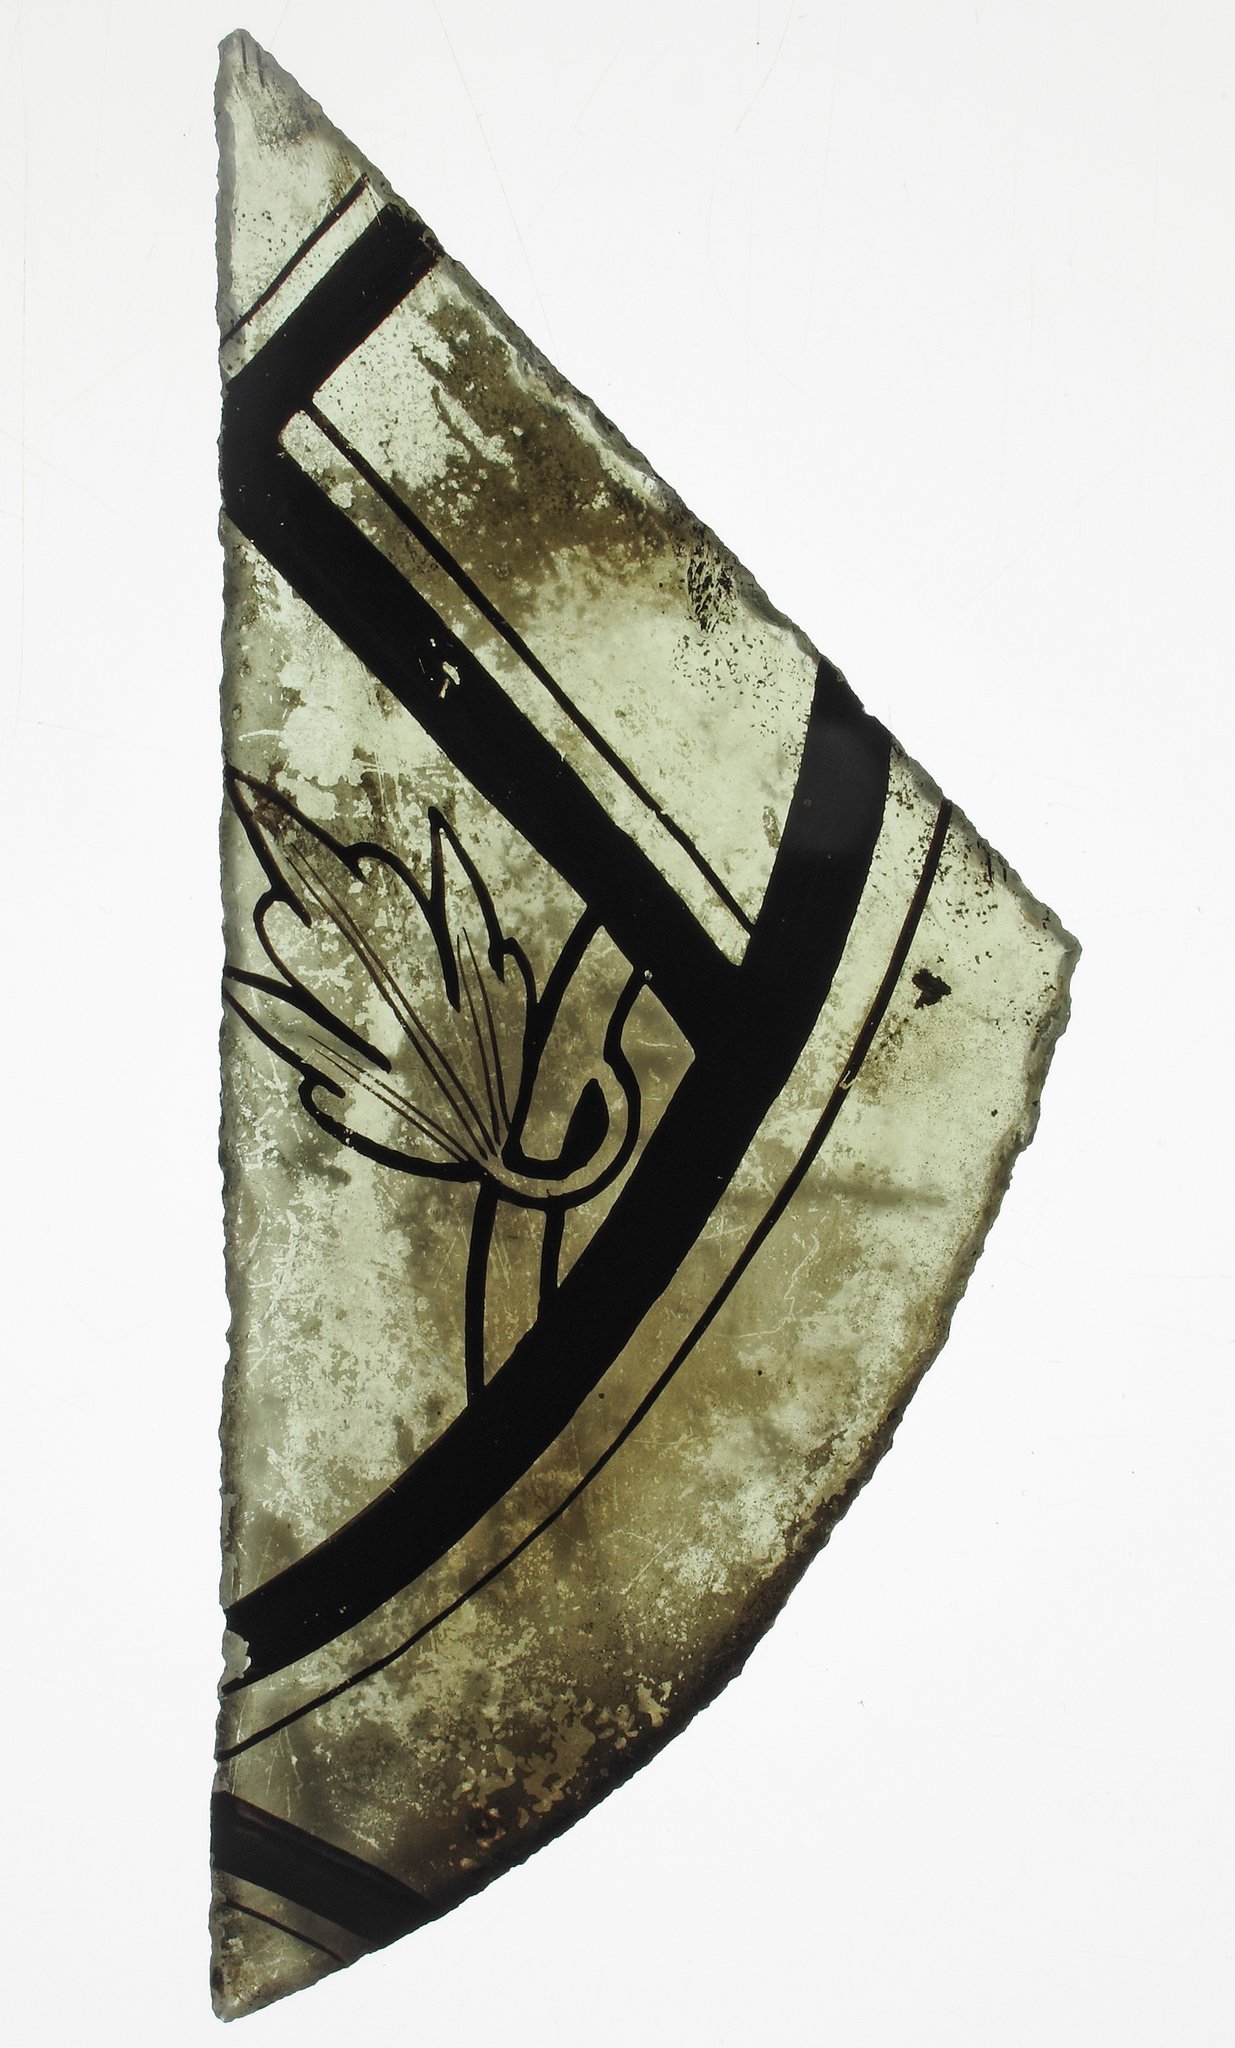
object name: fragment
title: Glass Fragment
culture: french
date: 1301-1400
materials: glass